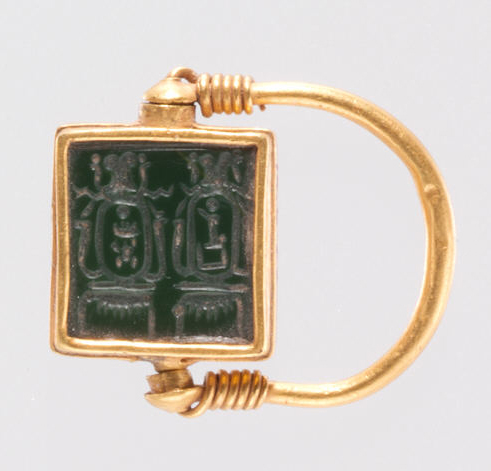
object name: ring, plaque, thutmose iii, hatshepsut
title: Finger Ring Inscribed with the Cartouches of Hatshepsut and Thutmose III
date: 1479-1458 BCE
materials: gold, jasper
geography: egypt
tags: cartouches